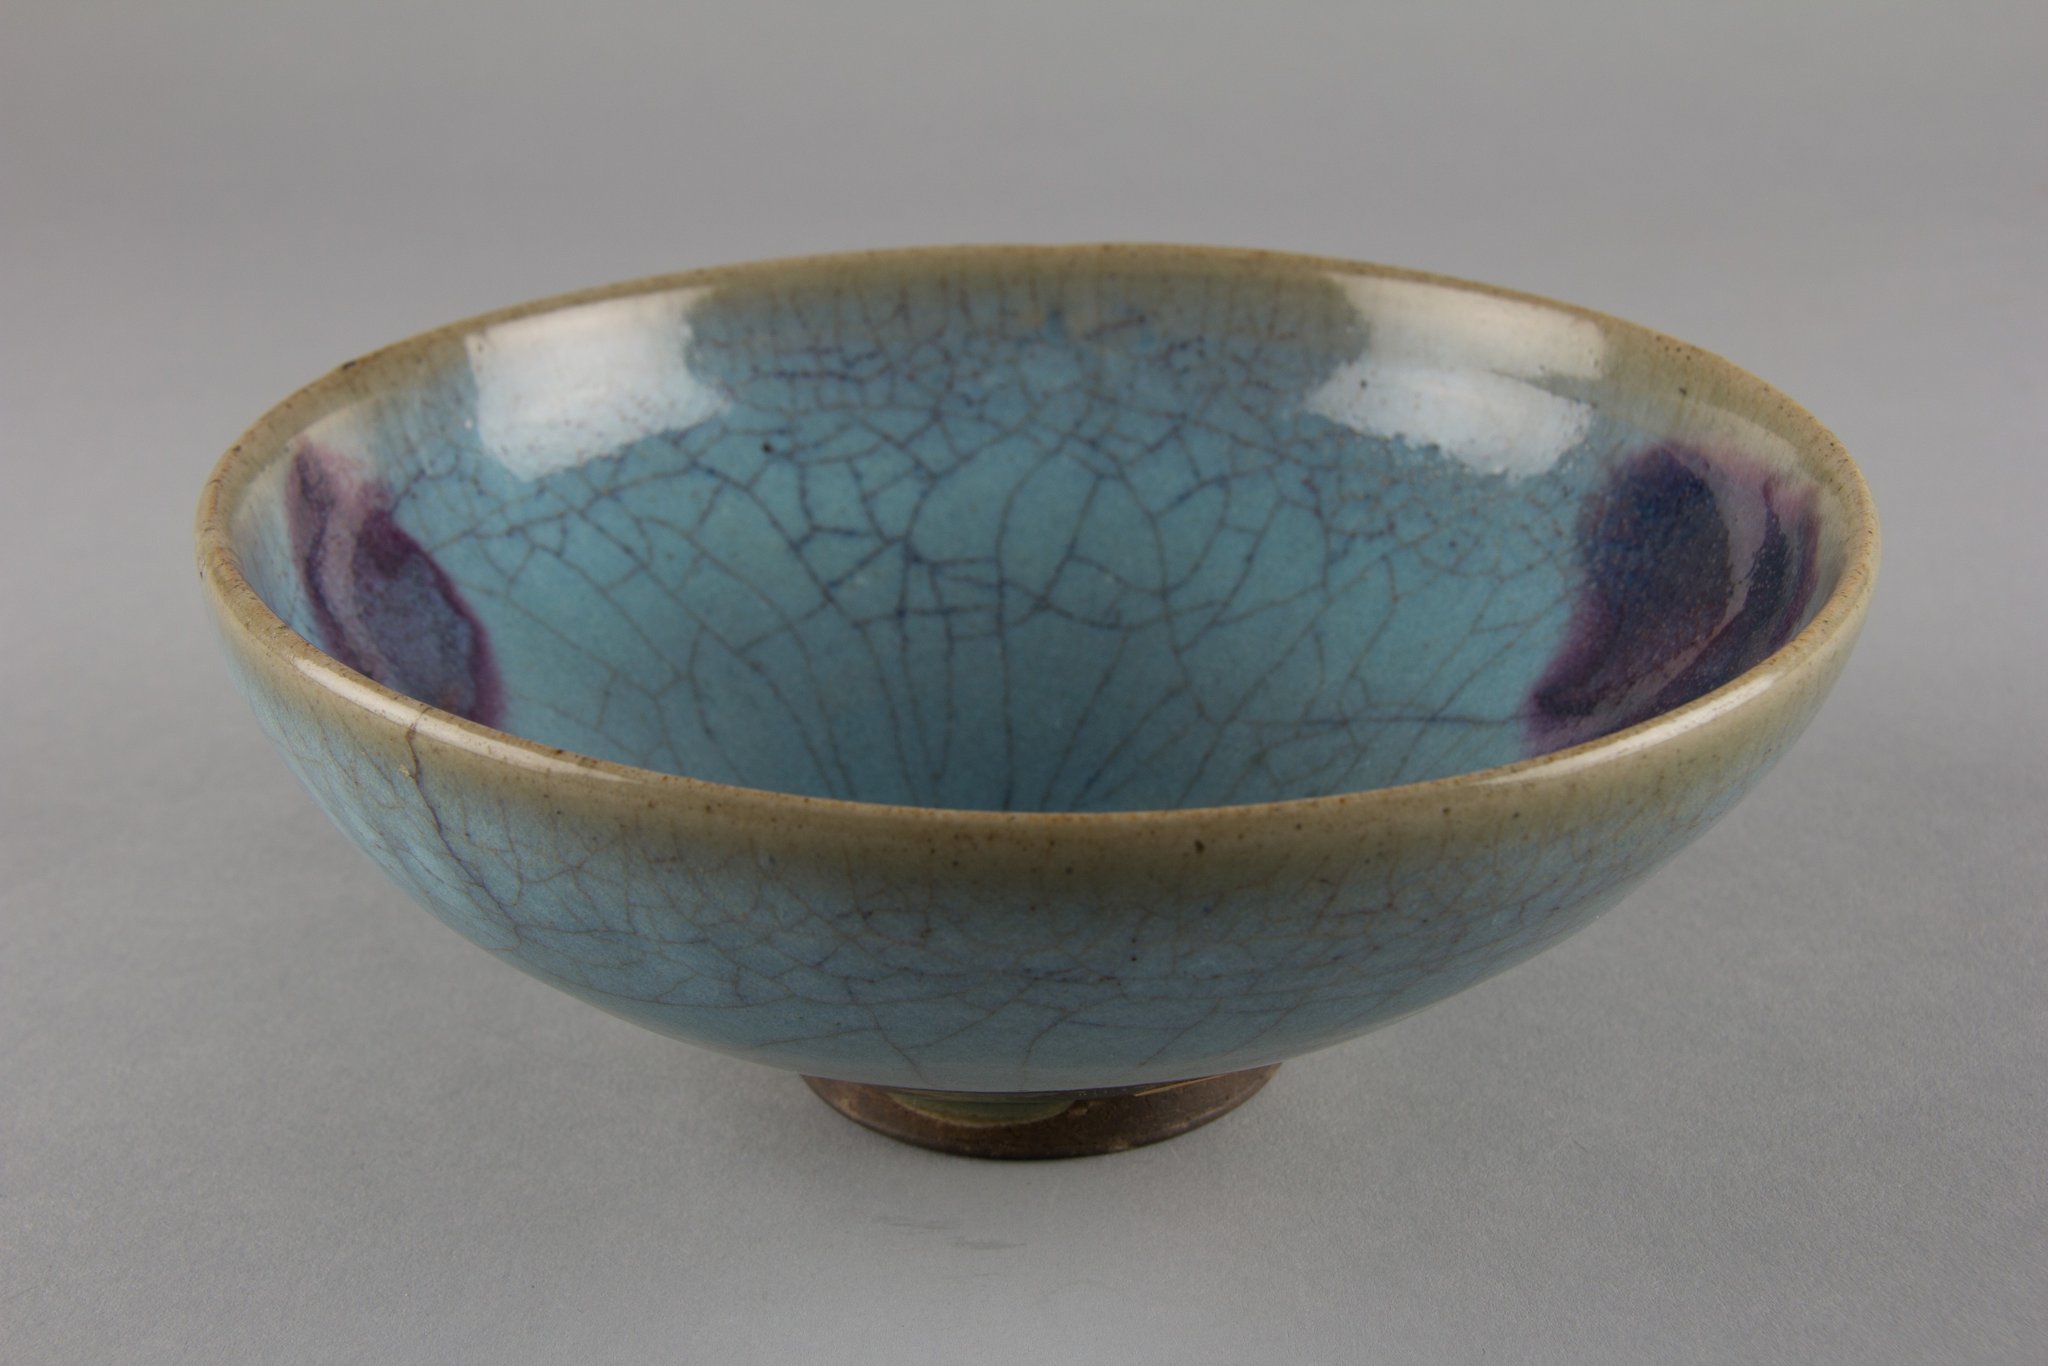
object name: bowl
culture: chinese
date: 1201-1400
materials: glaze, stoneware